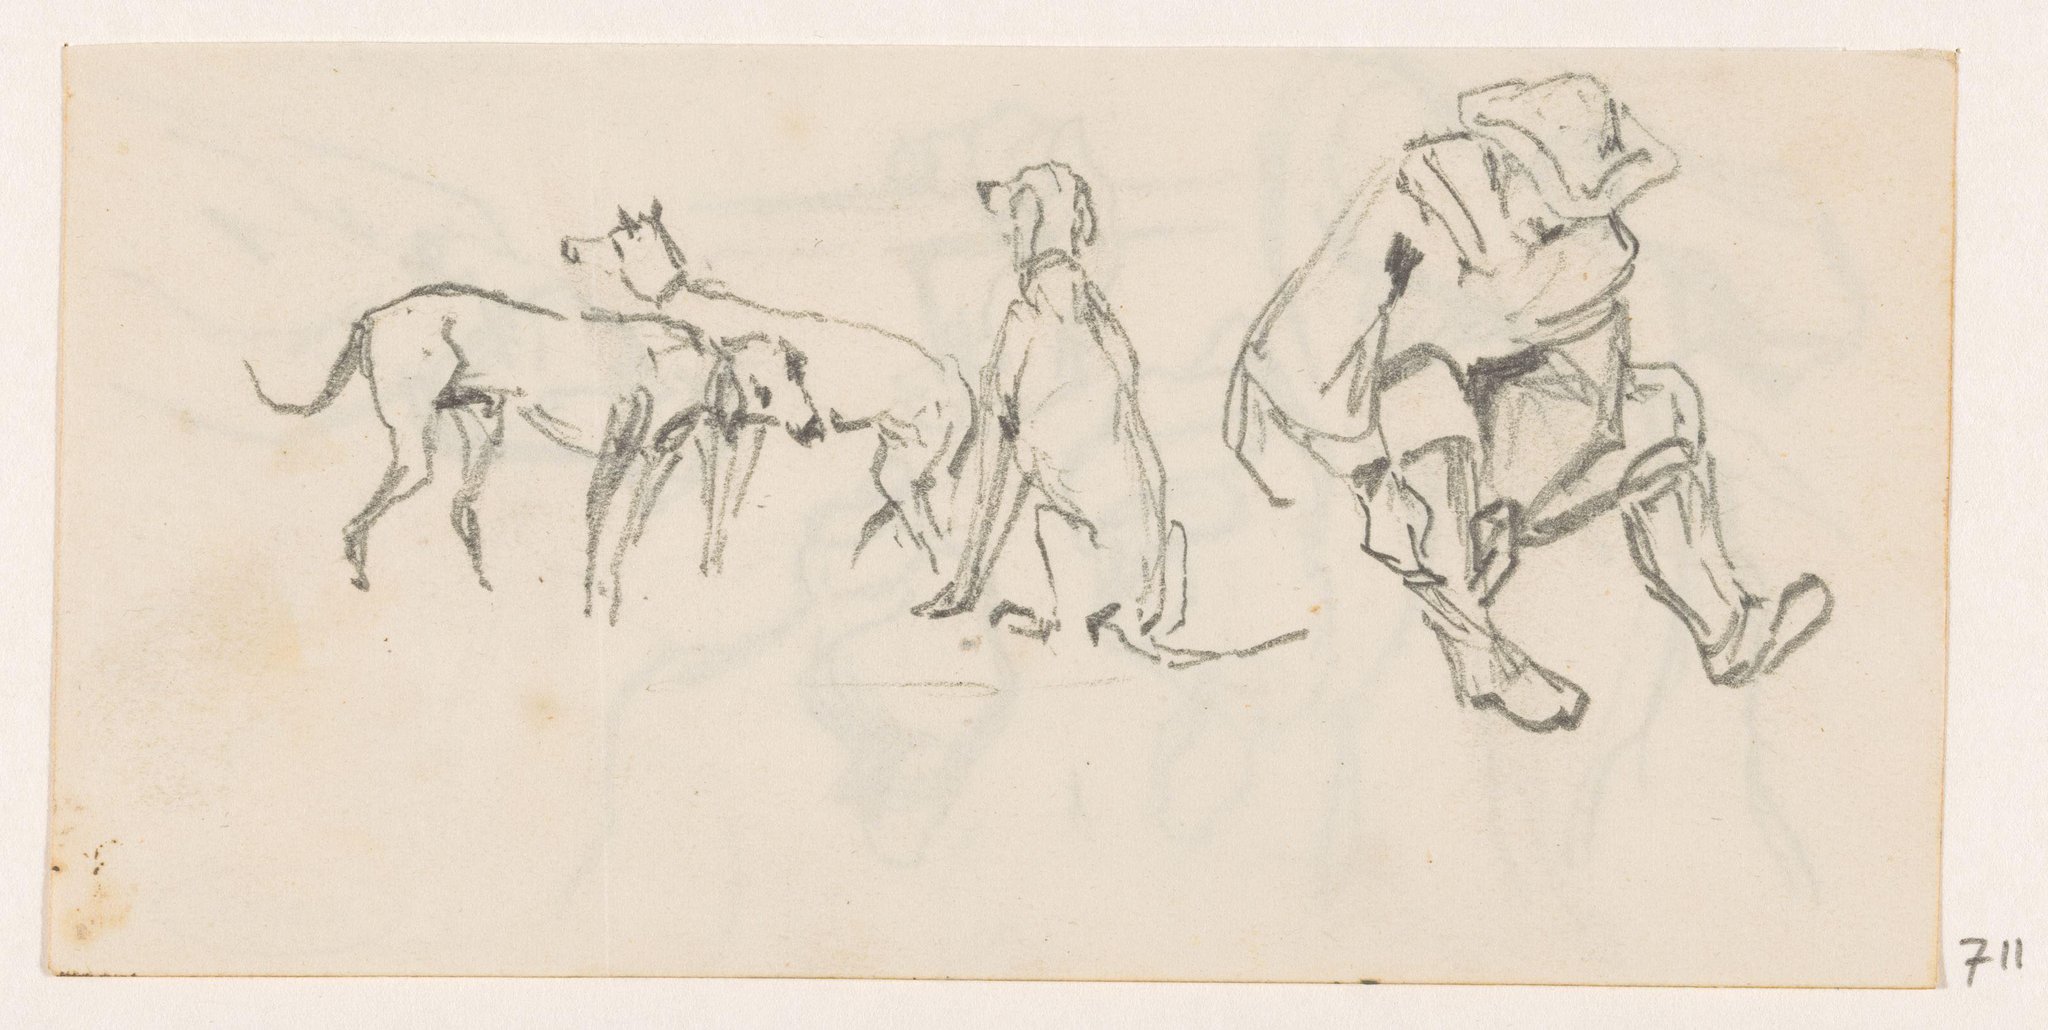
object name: drawing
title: Jachthonden en zittende man die laarzen aantrekt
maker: johannes tavenraat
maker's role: draughtsman, painter, print maker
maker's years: 1809-1881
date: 1840-1880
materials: paper, pencil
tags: hunting dogs, boots, dog